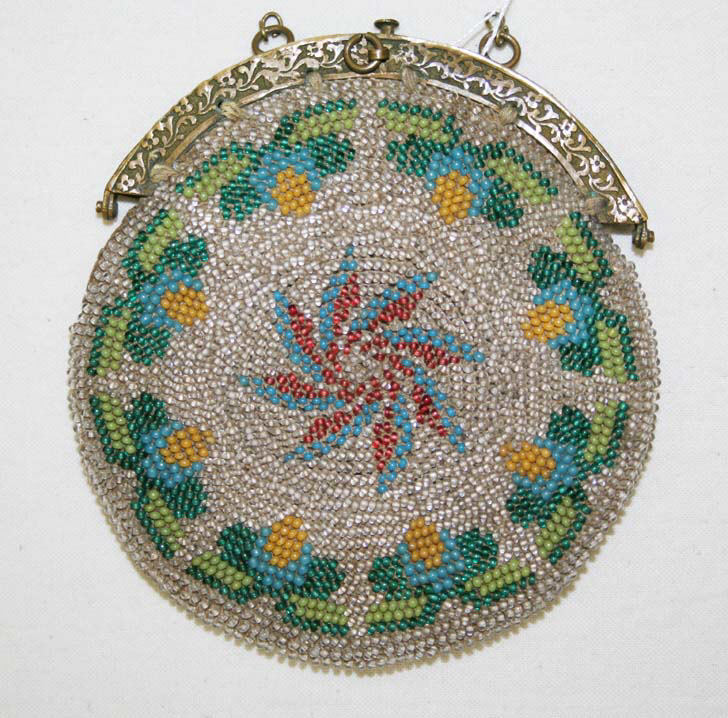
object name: bag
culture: european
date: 1800-1825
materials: glass